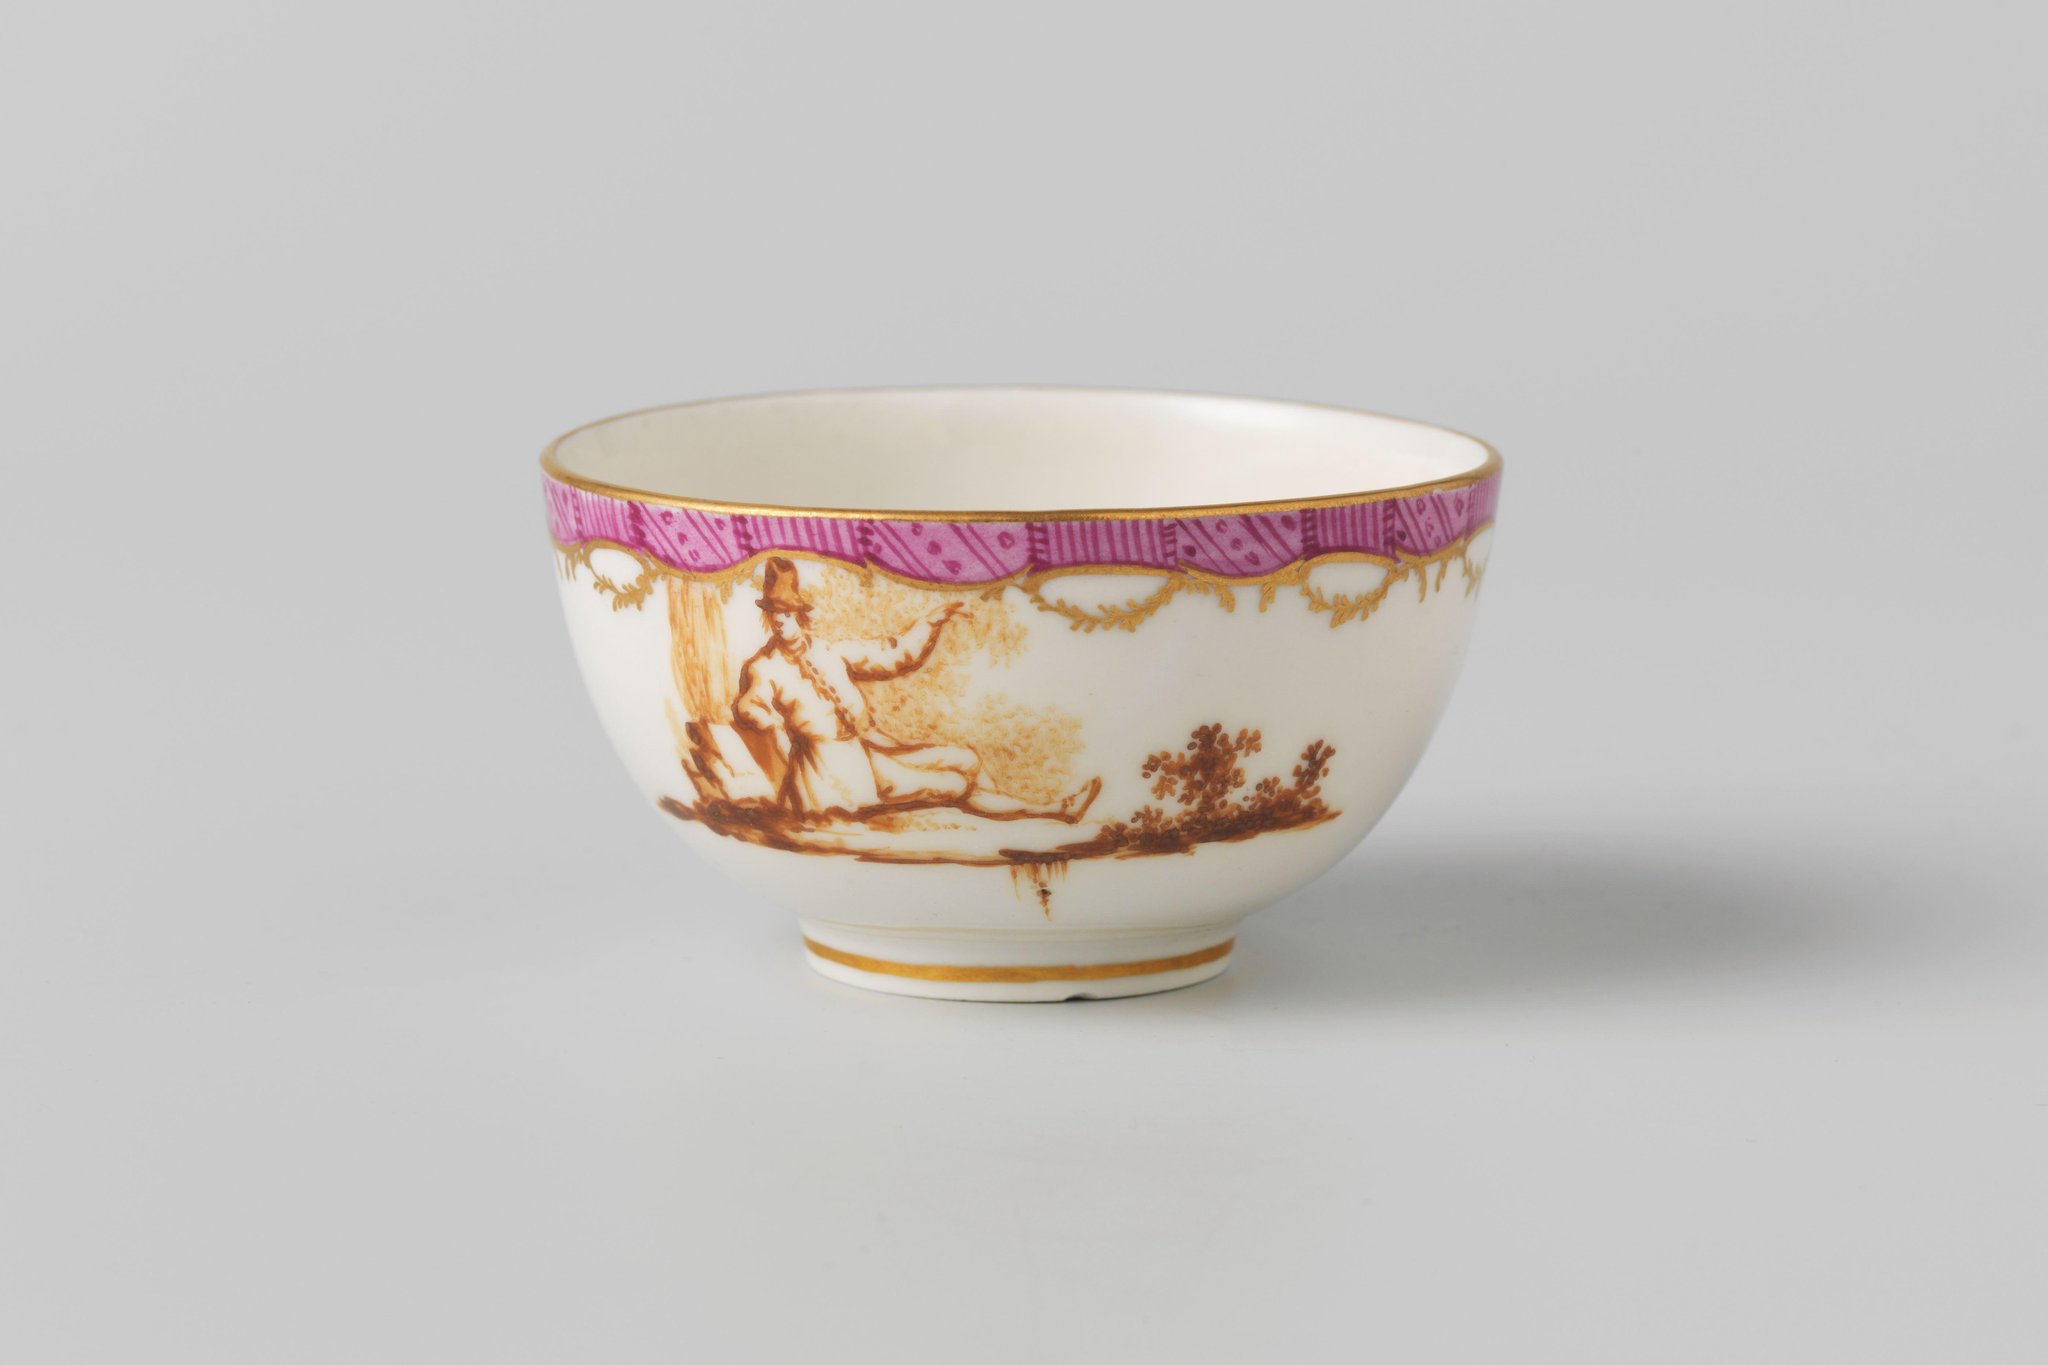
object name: cup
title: Theekop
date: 1774-1778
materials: porcelain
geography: loosdrecht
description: Theekop zonder oor van porselein. Beschilderd in sepia met figuren in een landschap. Langs de randen een lila fries tussen gouden biezen.